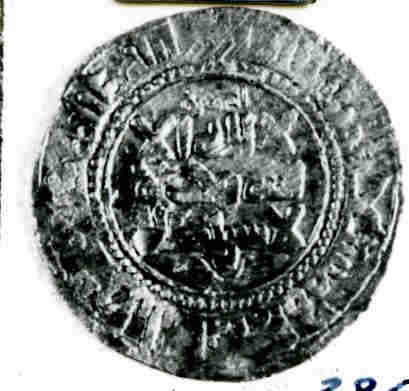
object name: coin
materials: copper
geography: uzbekistan